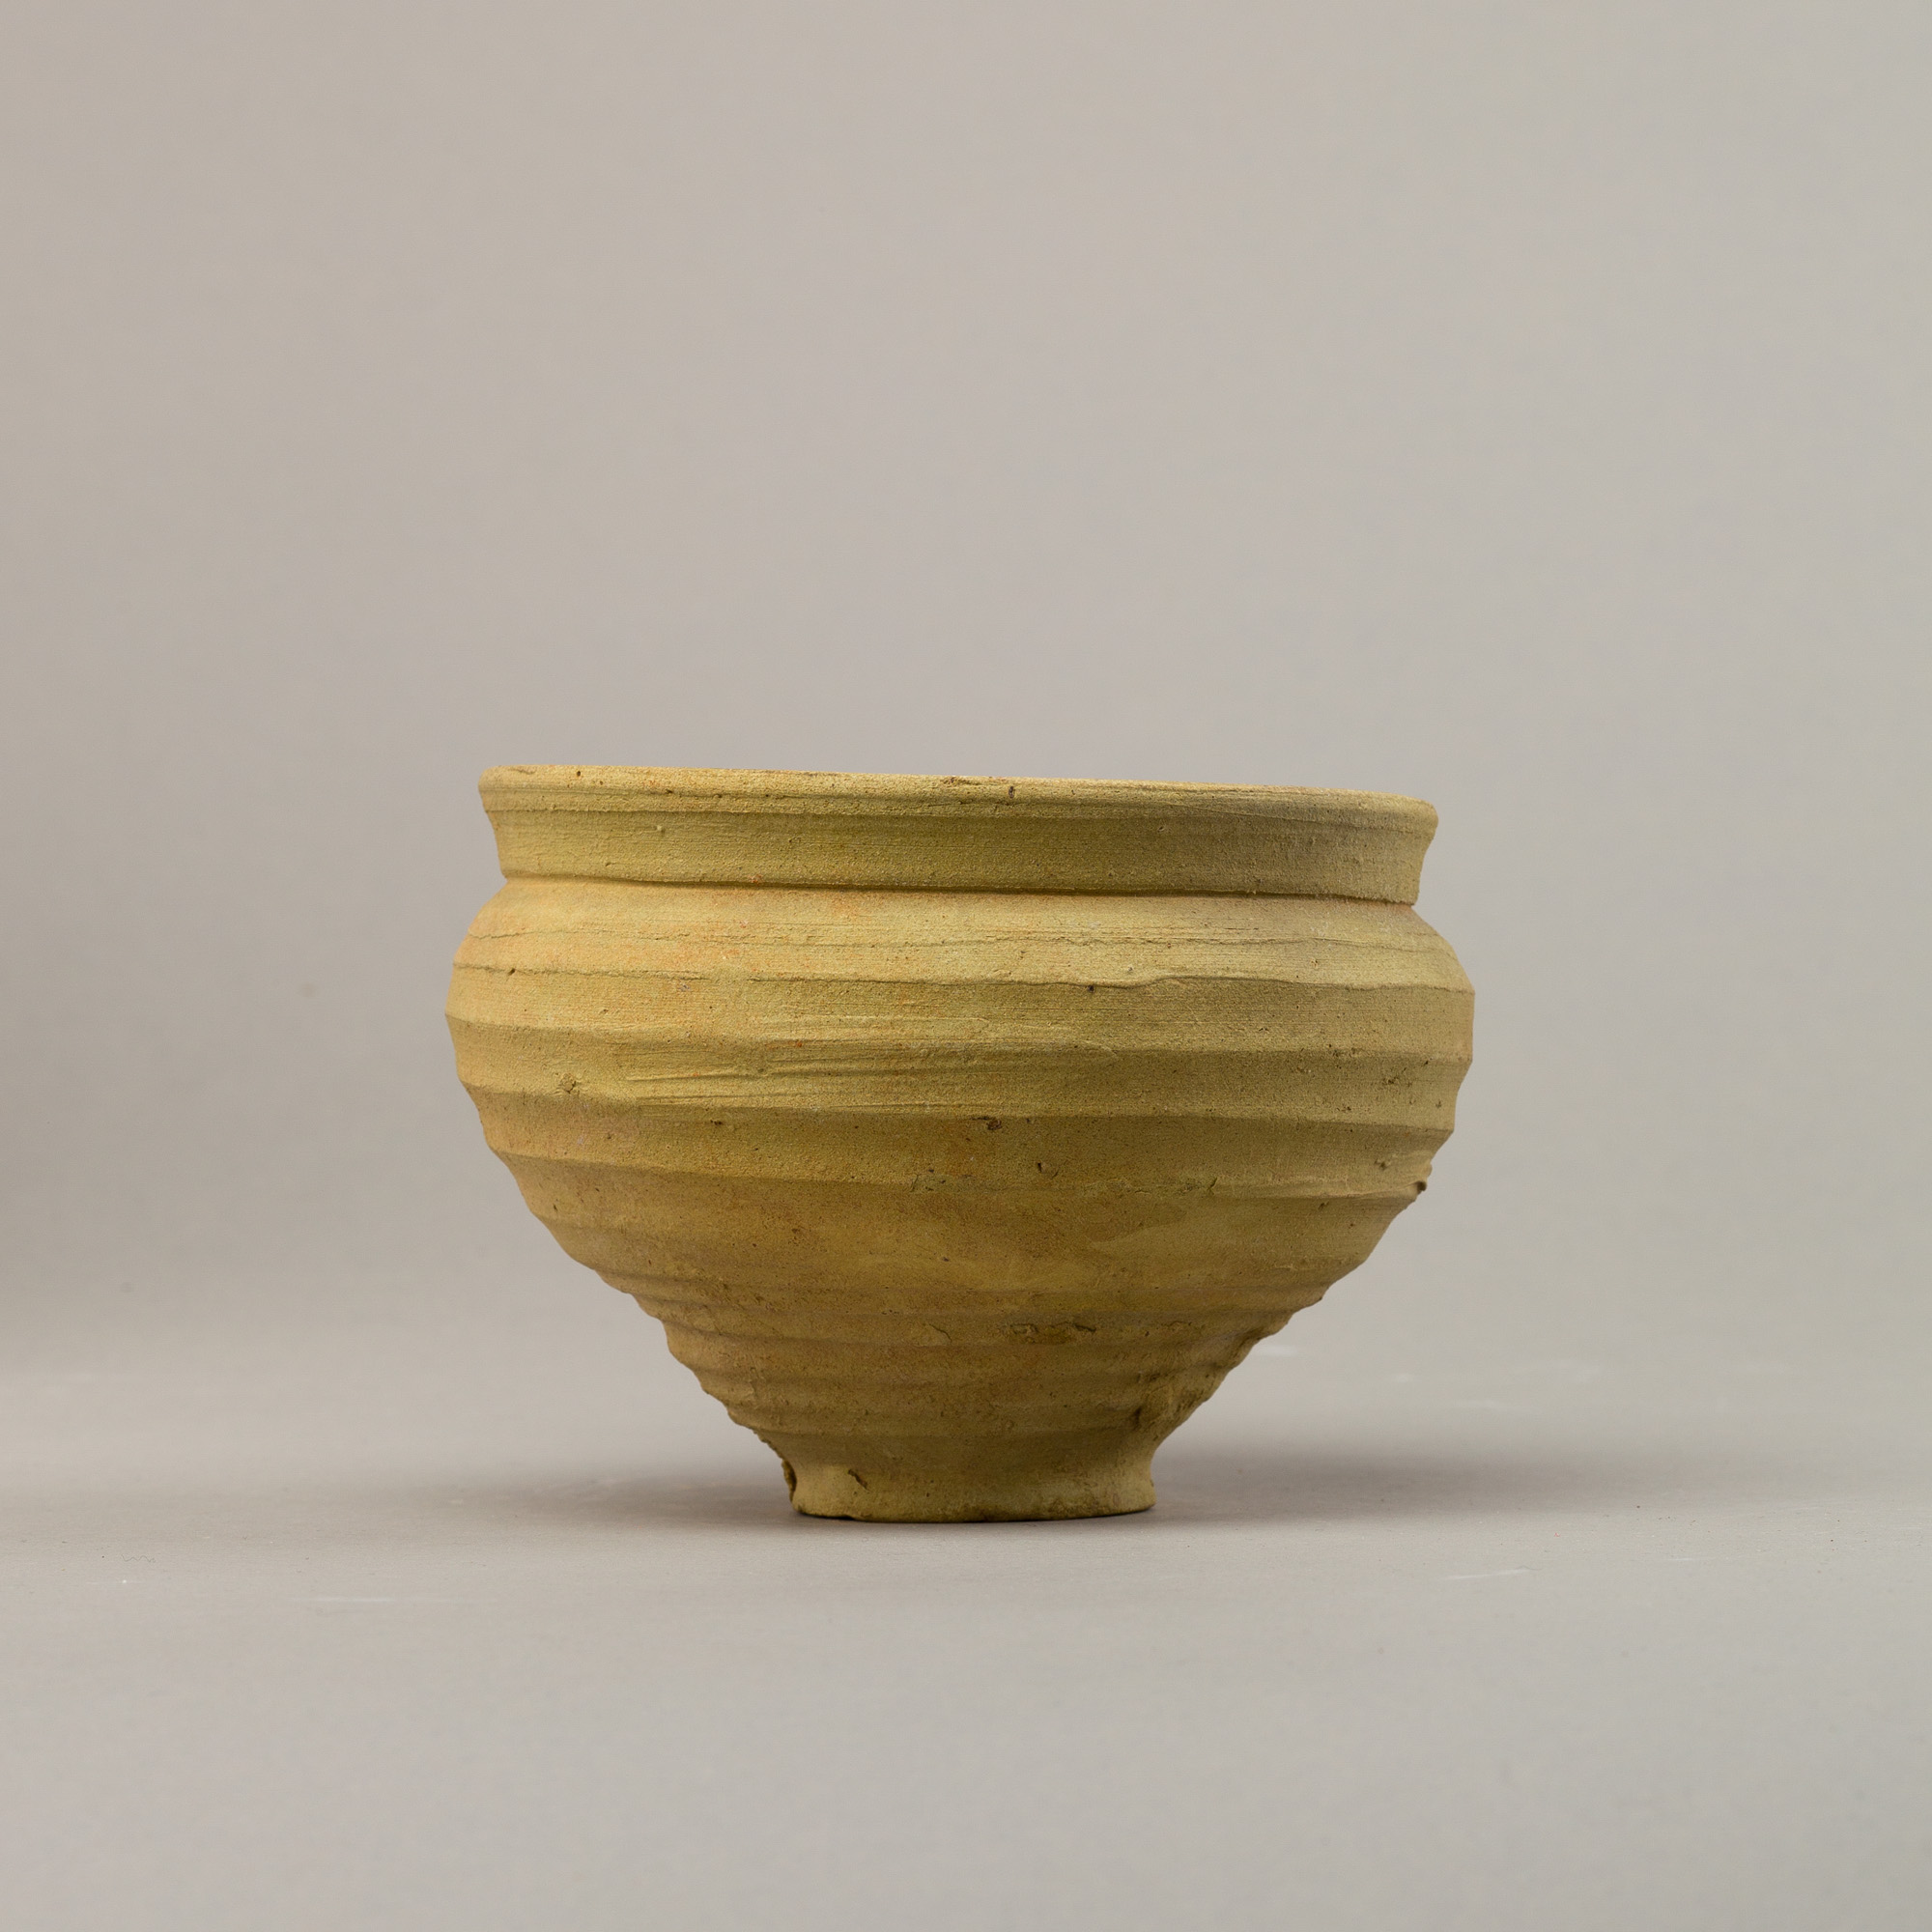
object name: bowl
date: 1-100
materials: pottery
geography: egypt